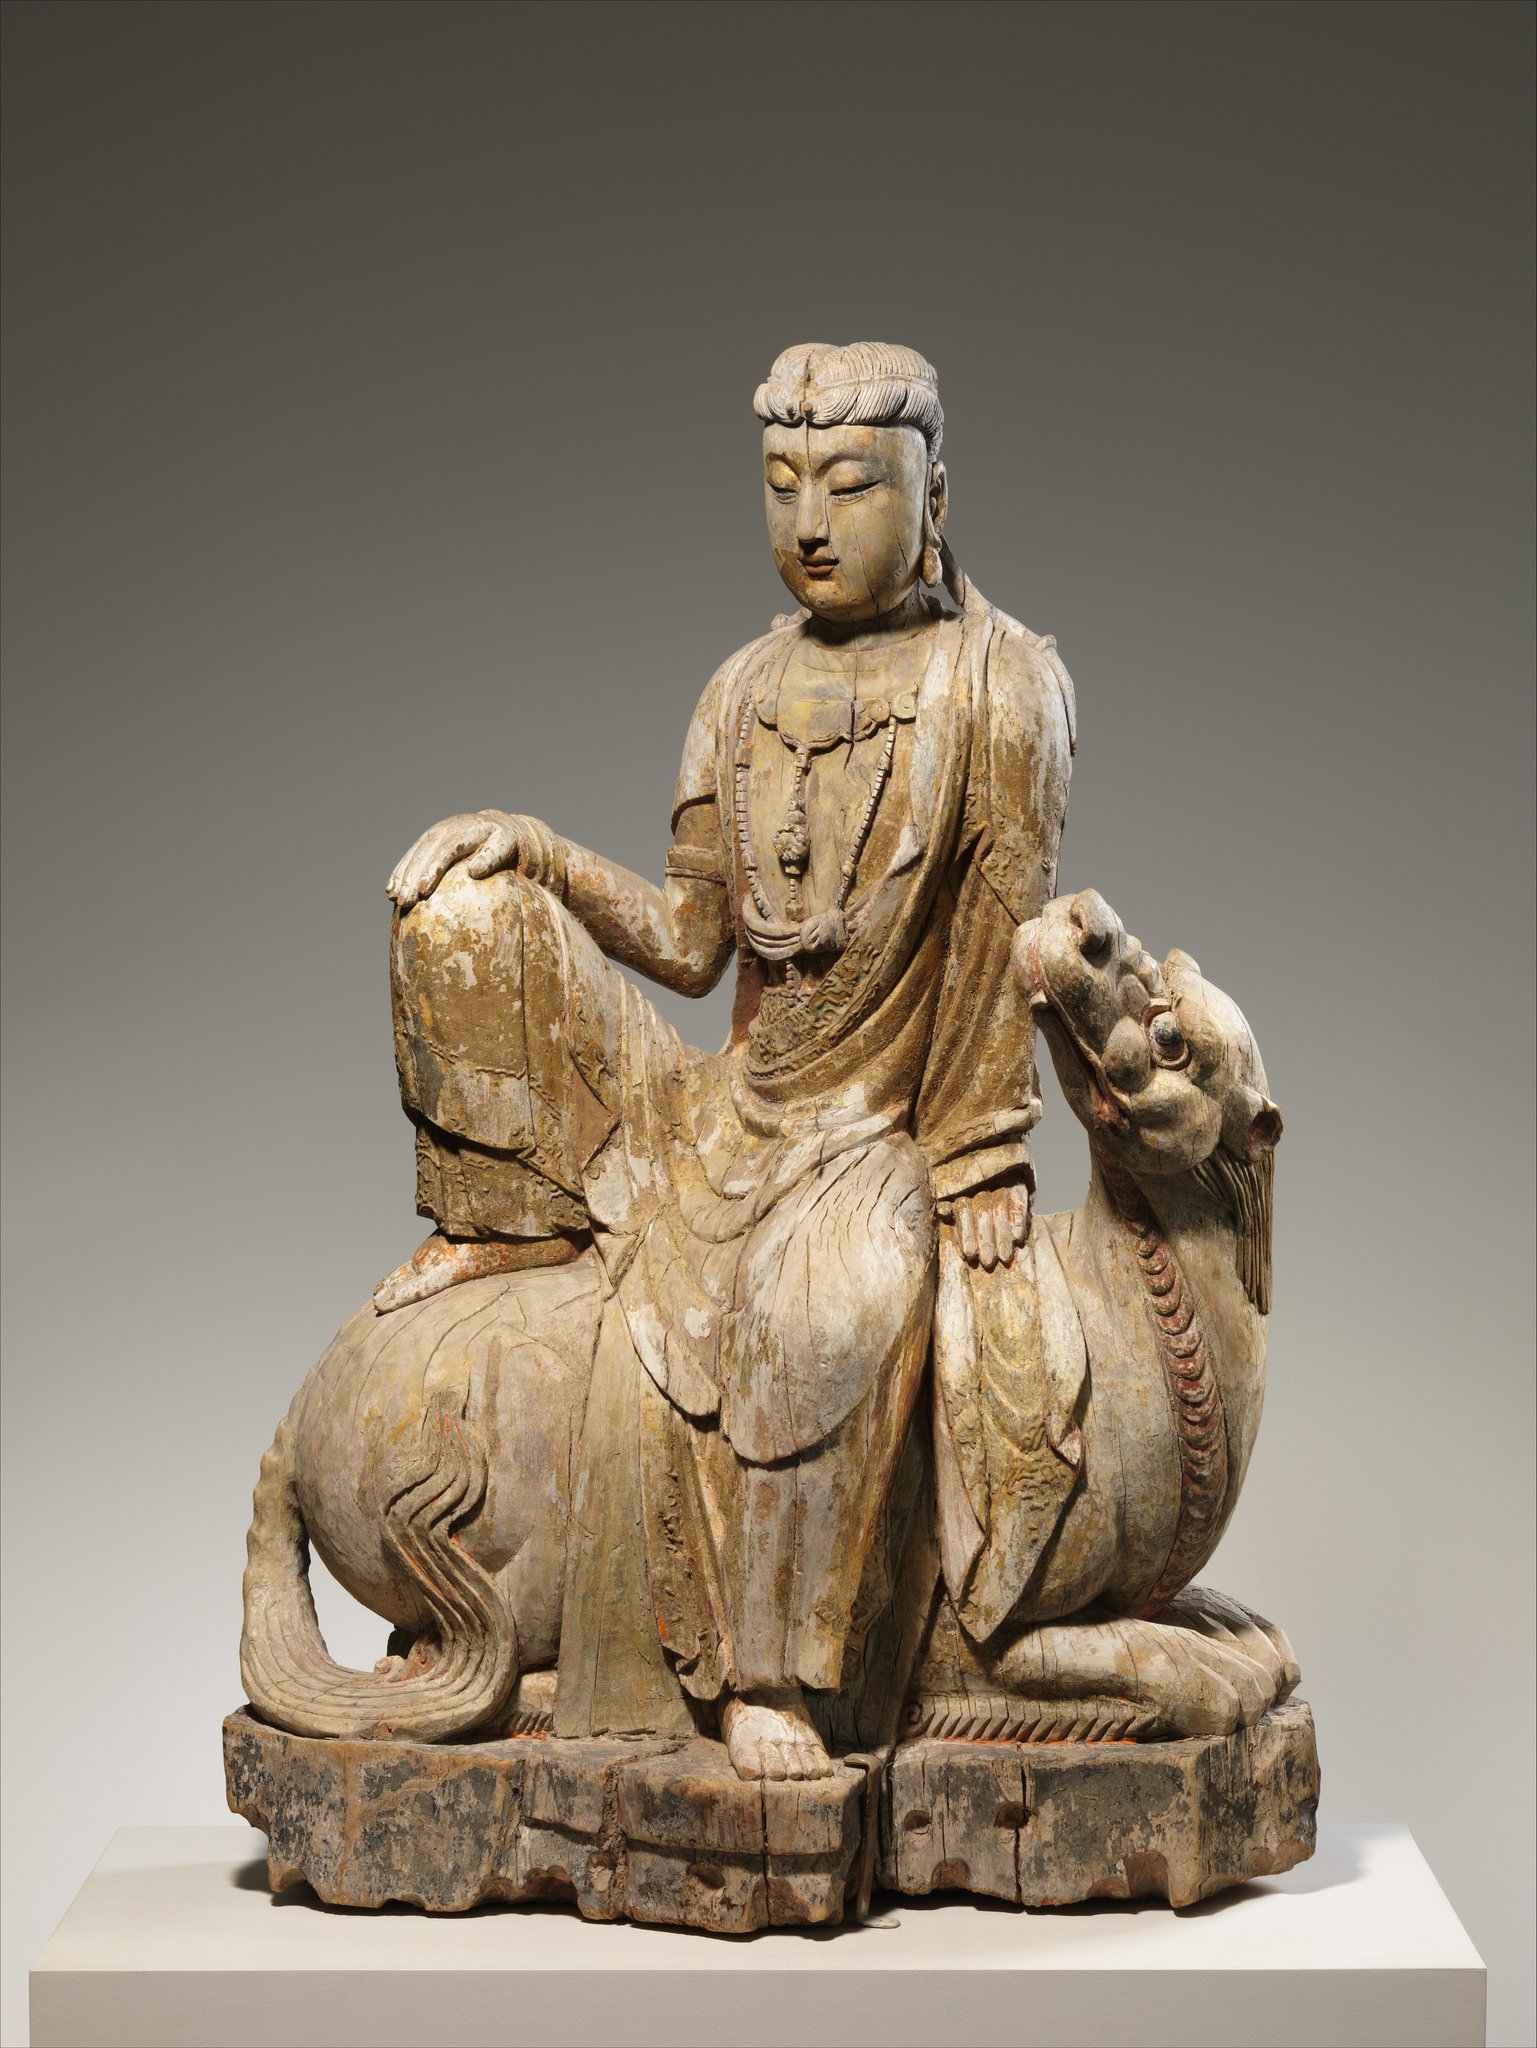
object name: figure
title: Bodhisattva Avalokiteshvara of the Lion's Roar, or Simhanada Avalokiteshvara (Shi Hou Guanyin)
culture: chinese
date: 1467-1633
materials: pigment, wood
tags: lions,buddhism,avalokiteshvara,bodhisattvas